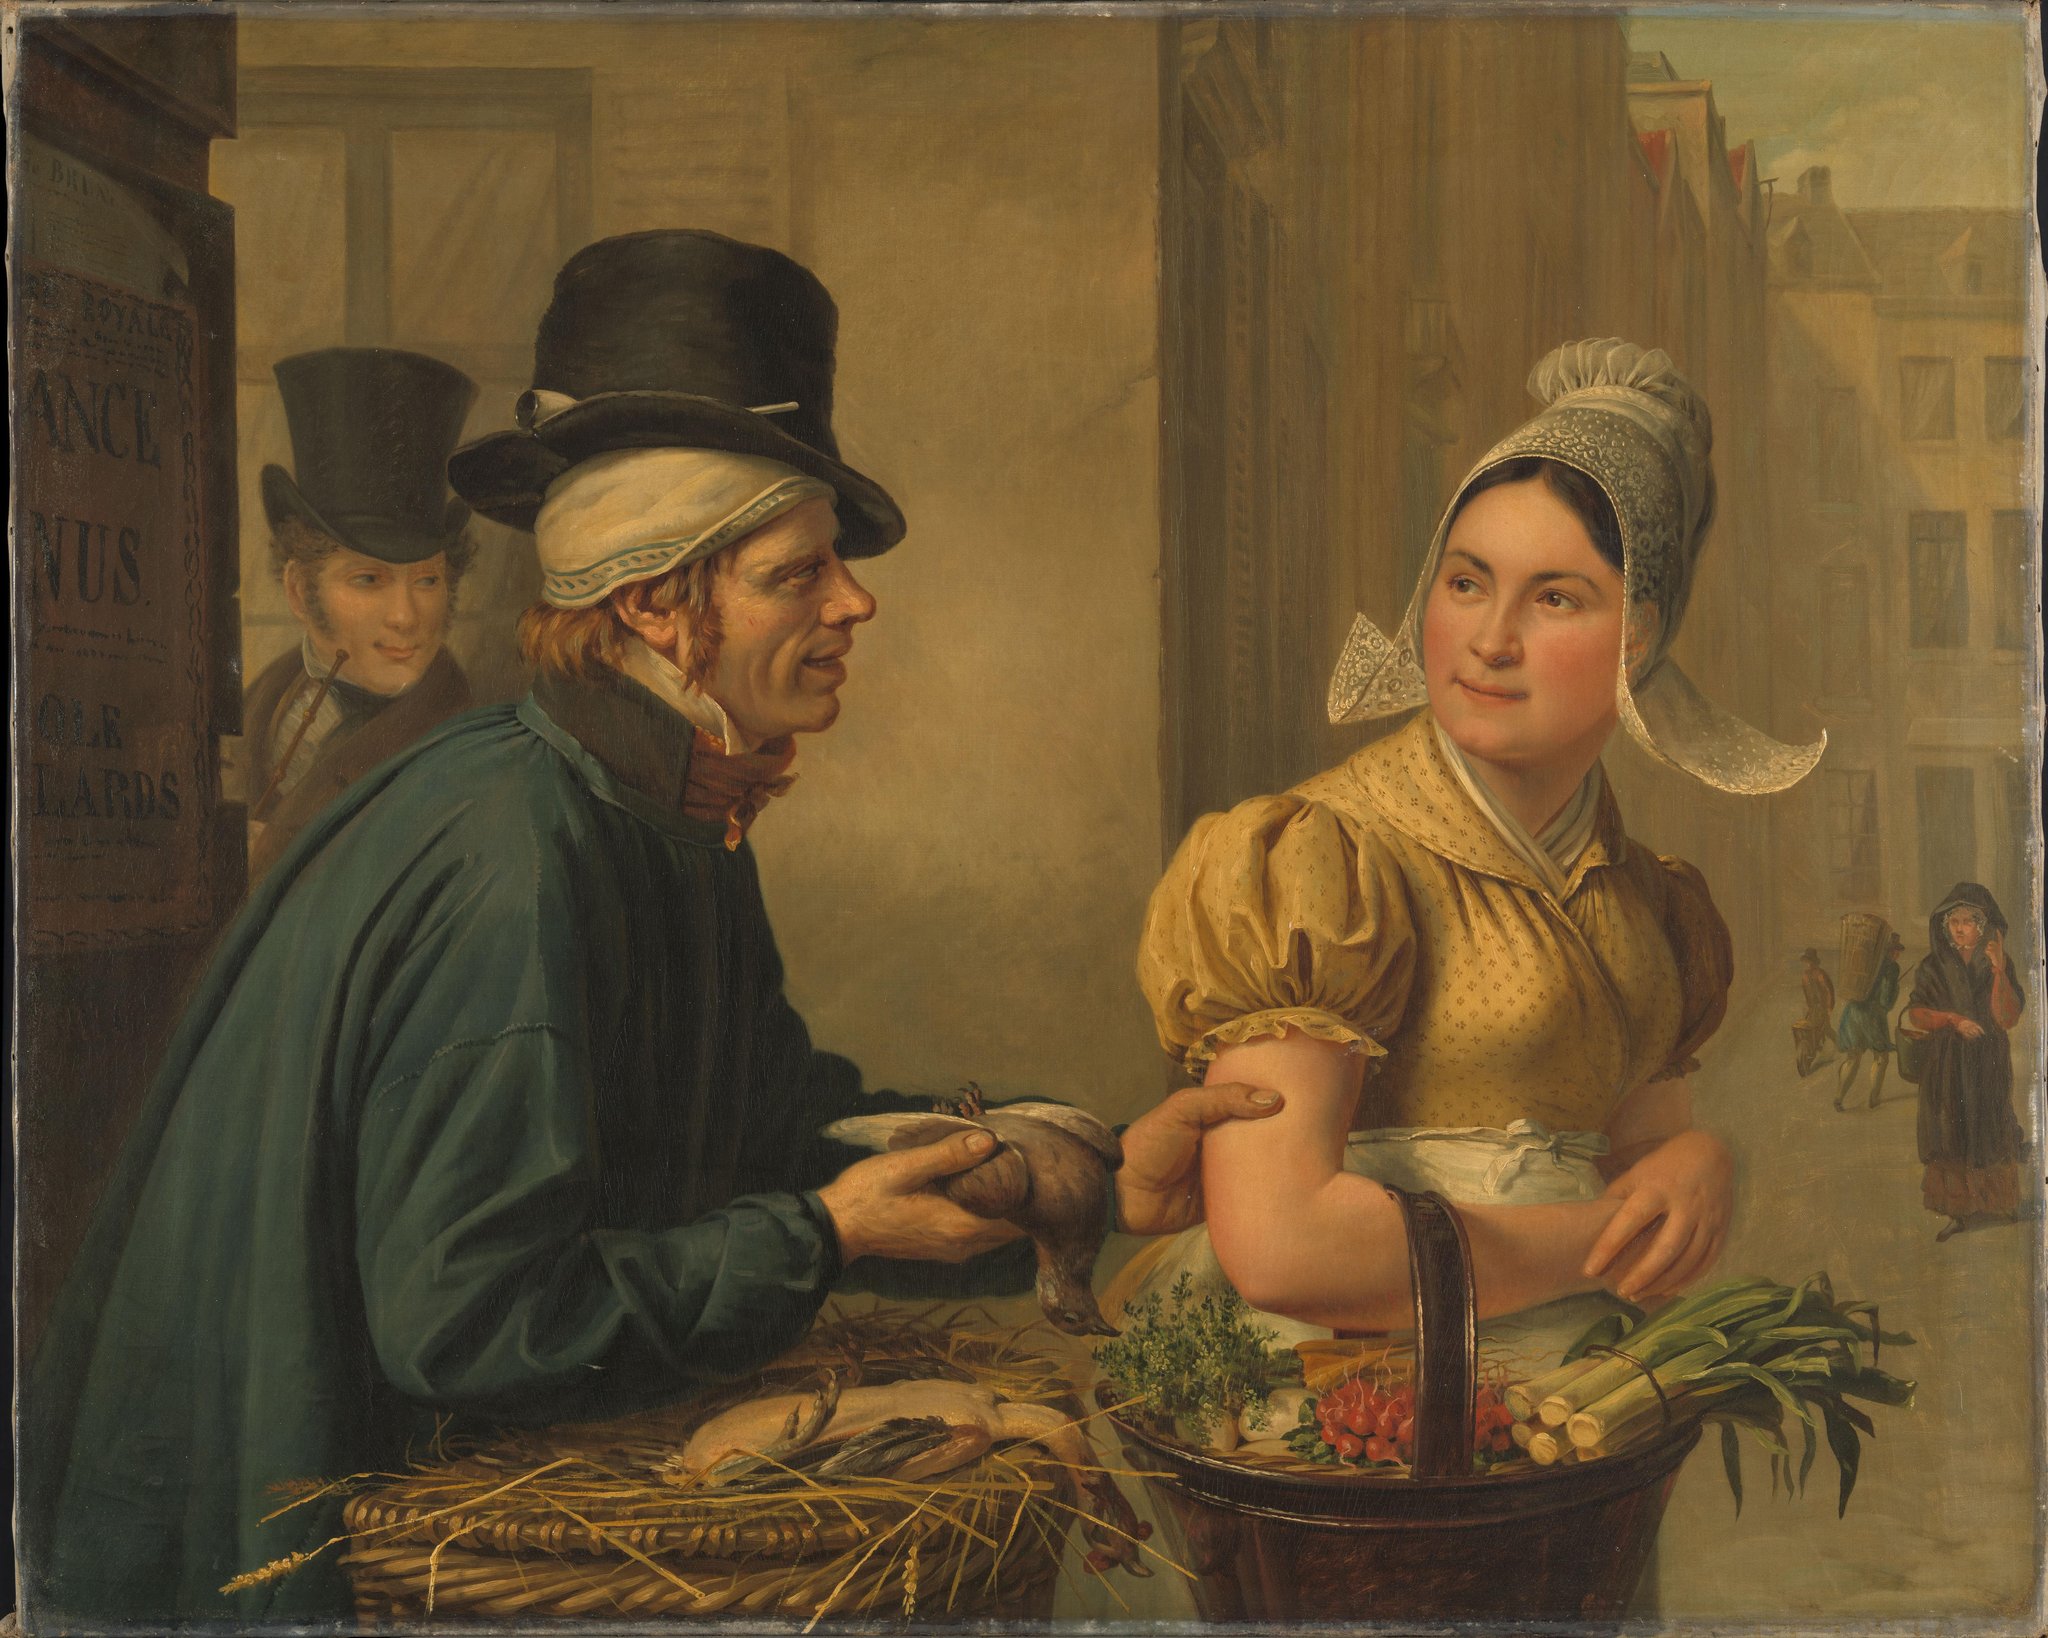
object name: painting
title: The Poultryman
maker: ignace brice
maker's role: painter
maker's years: 1795-1866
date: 1827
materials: canvas, oil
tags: bird seller, going to the market, market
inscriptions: signature and date: ‘Brice 1827’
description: De poelier. Straatgezicht waarin een man probeert aan een jonge vrouw met een mand met groenten een duif te verkopen.